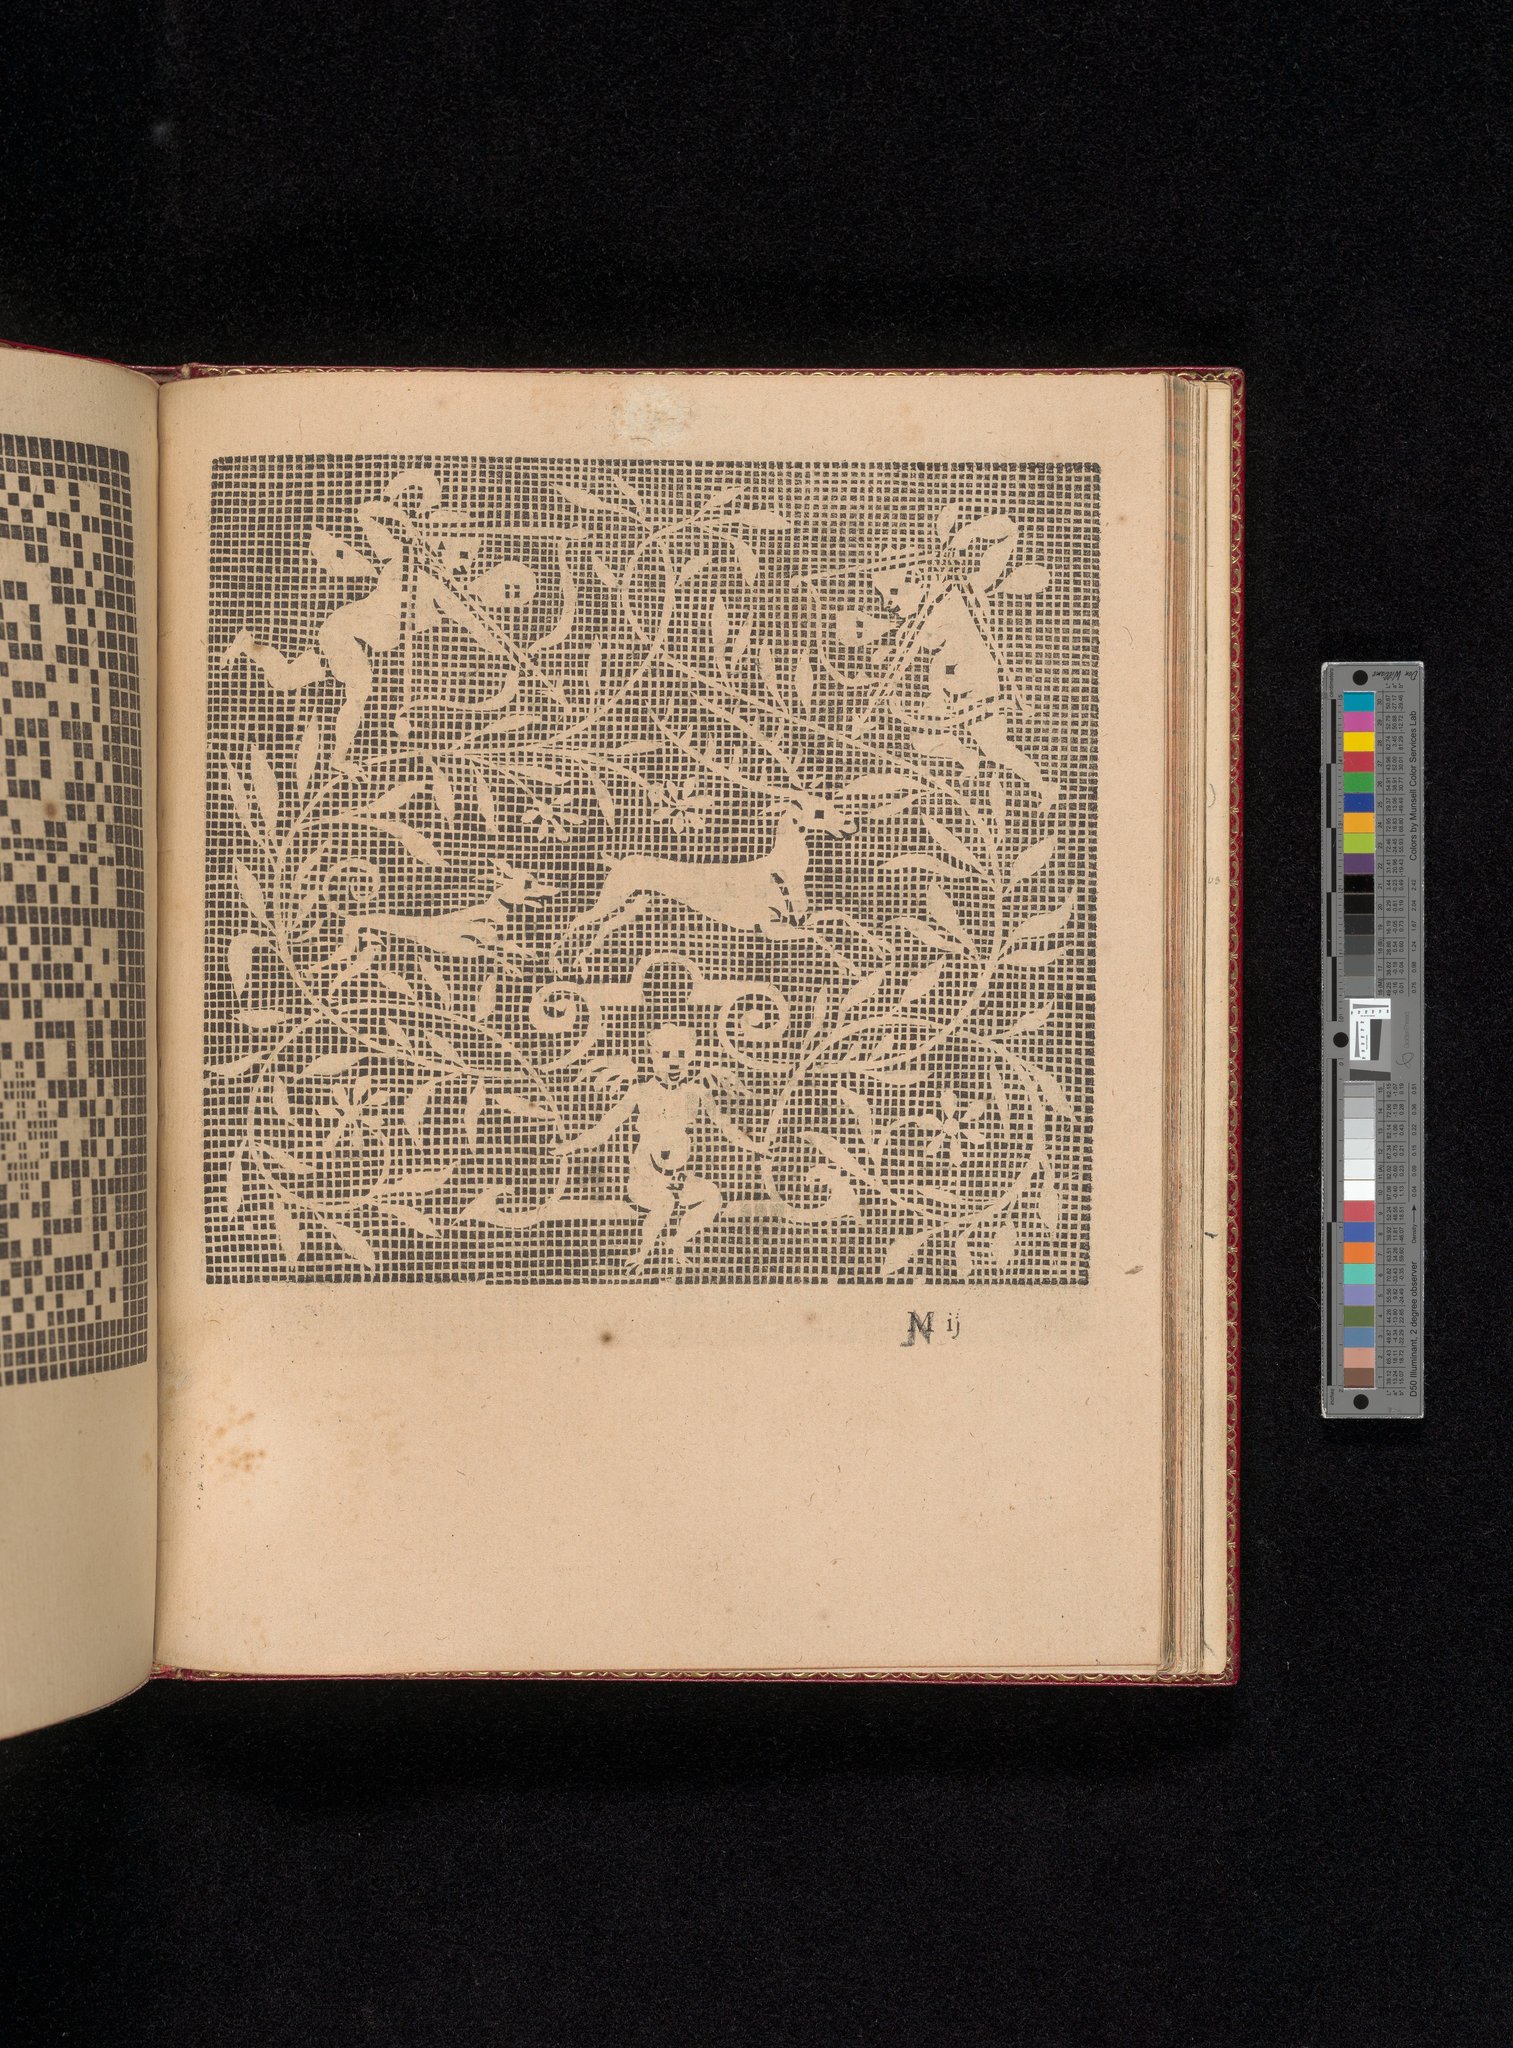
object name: book print ornament architecture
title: Les Singuliers et Nouveaux Portraicts... page 50 (recto)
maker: federico de vinciolo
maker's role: designer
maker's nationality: italian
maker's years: 1582-1599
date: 1588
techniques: woodcut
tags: putti,deer,dogs